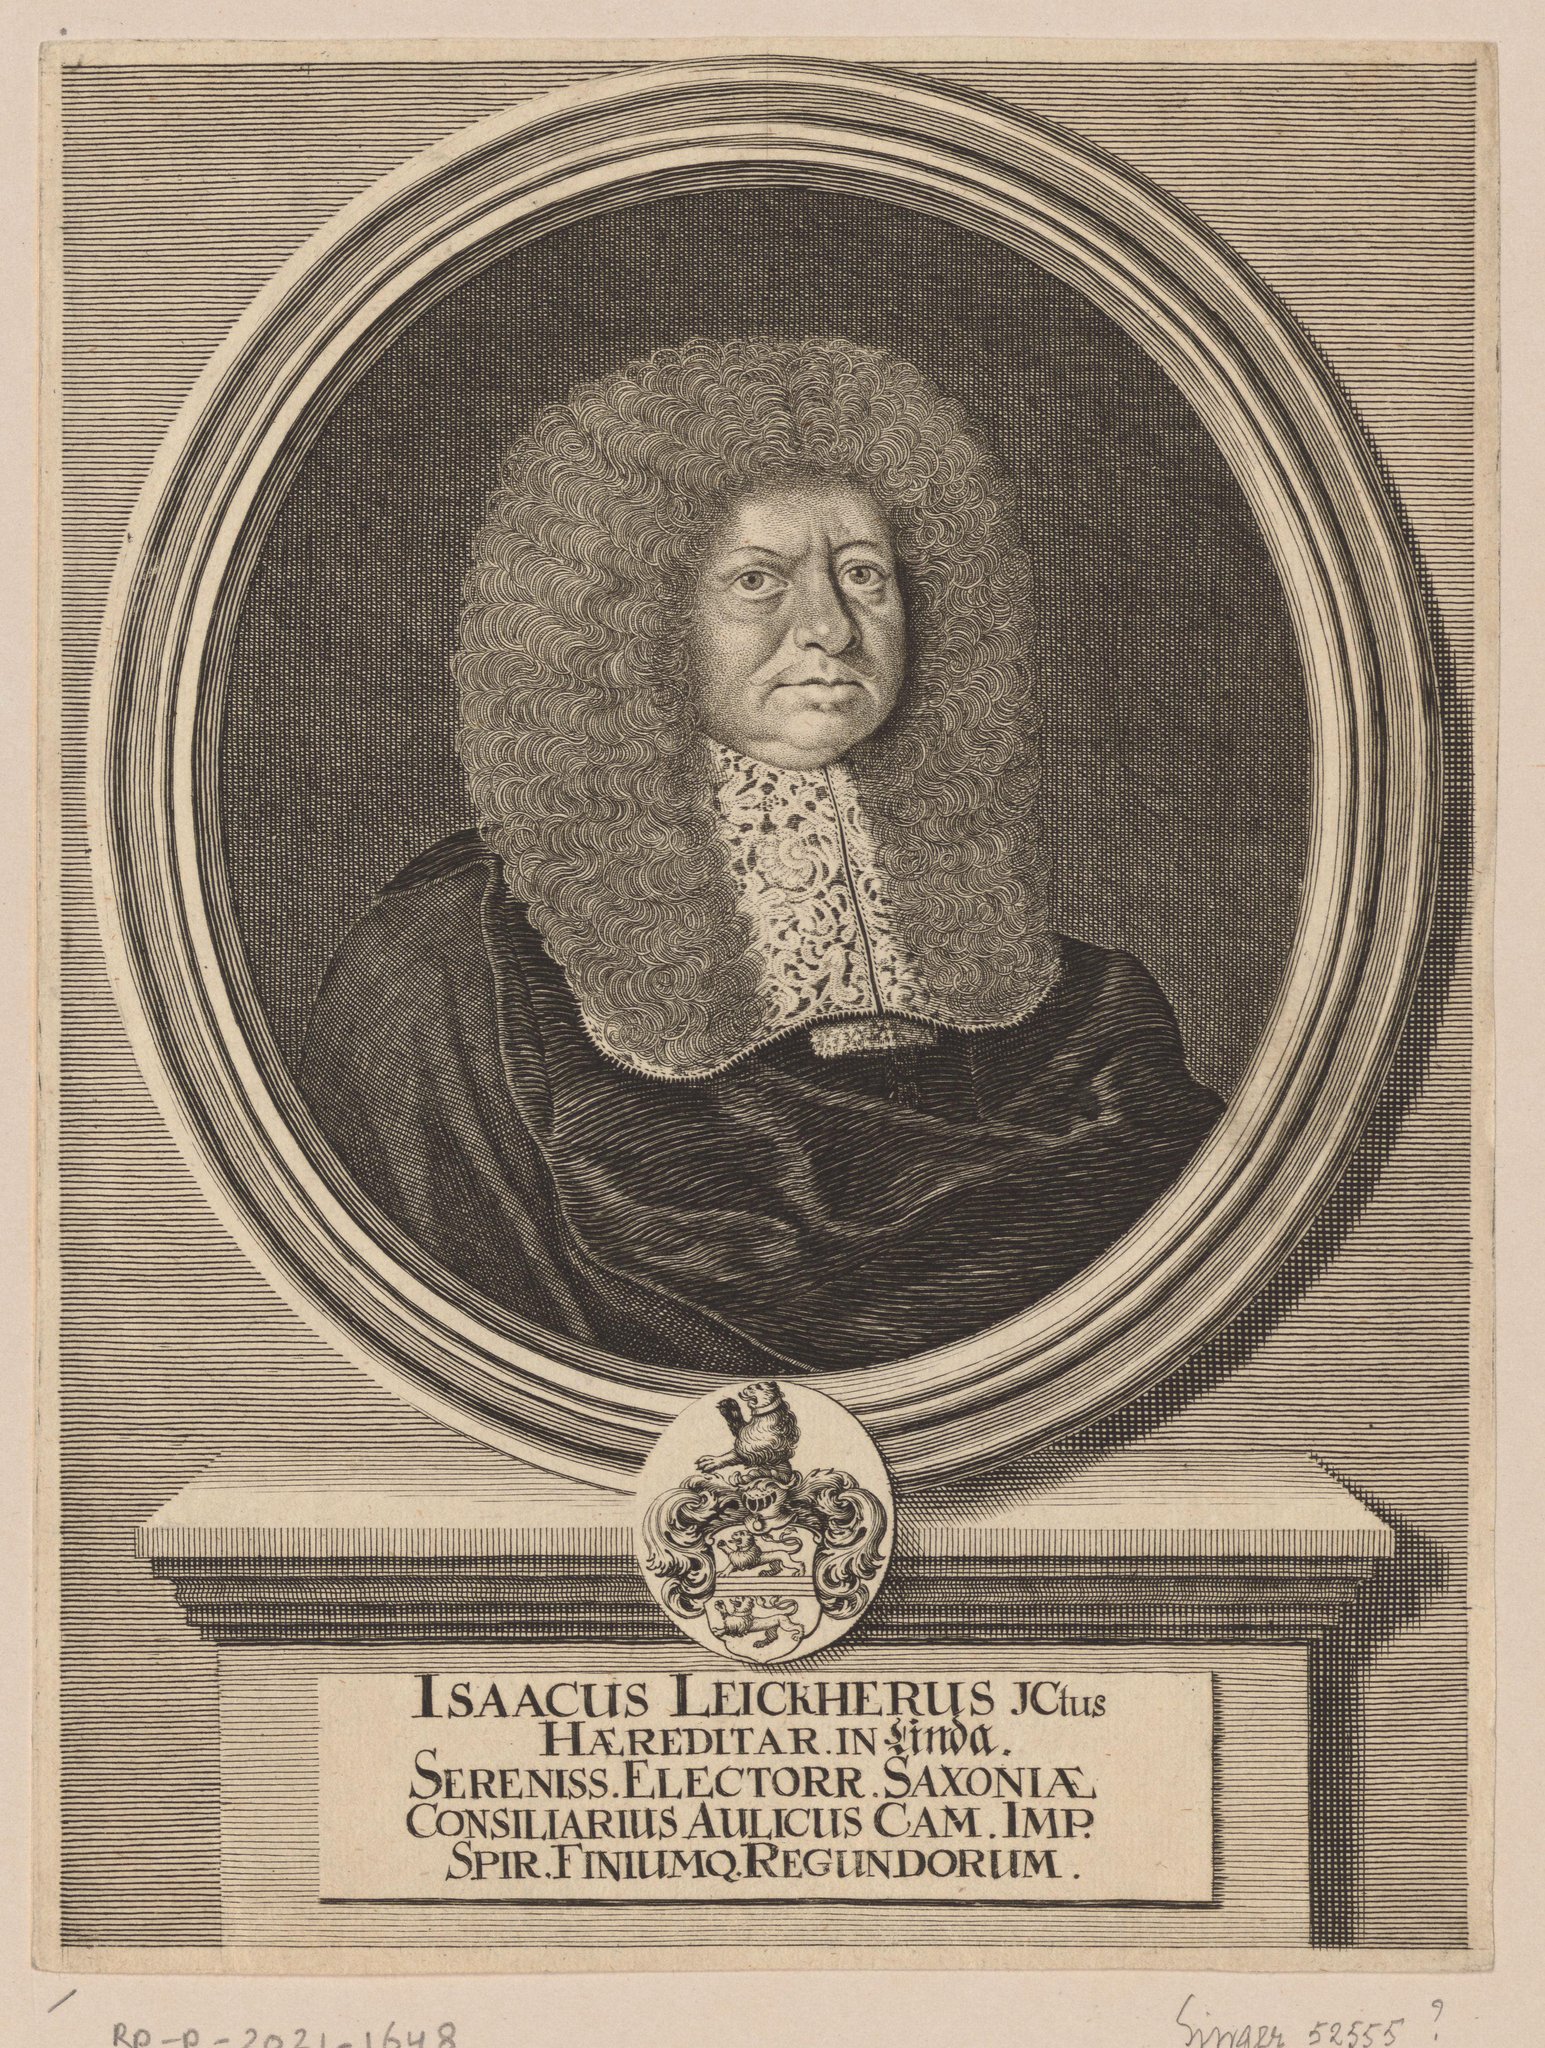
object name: print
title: Portret van Isaac Leickher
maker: Anonymous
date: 1660-1700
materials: paper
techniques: engraving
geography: germany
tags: ornament ~ medallion, historical persons, wig, armorial bearing, heraldry